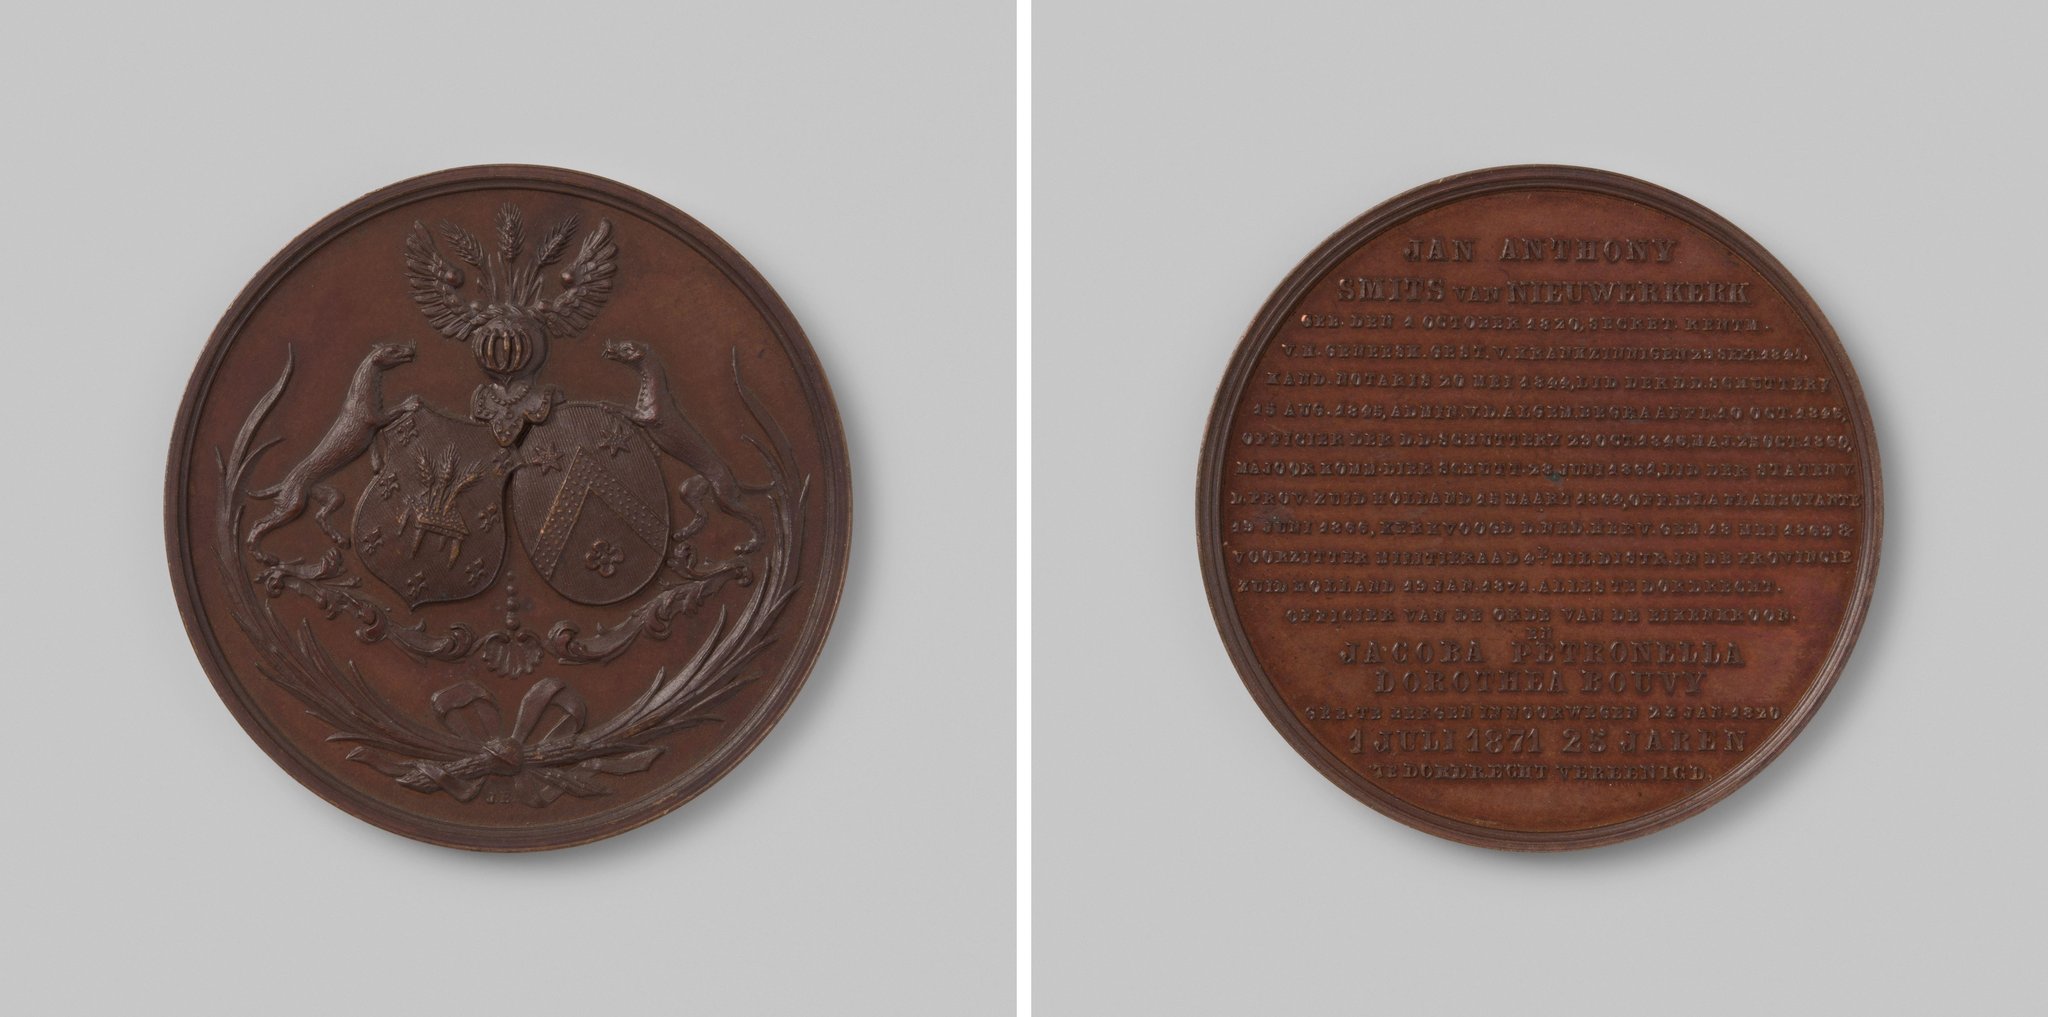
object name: marriage medal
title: Vijfentwintigjarig huwelijk van Jan Anthony Smits van Nieuwerkerk, lid van de Staten van Zuid-Holland en Jacoba Petronella Dorothea Bouvy te Dordrecht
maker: jacob samuel cohen elion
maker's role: draughtsman, painter, print maker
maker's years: 1840-1893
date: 1871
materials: bronze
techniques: striking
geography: amsterdam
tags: dordrecht, johan anthony smits van nieuwerkerk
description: Bronzen penning. Voorzijde: twee wapenschilden onder een gevleugelde helm, geflankeerd door twee dieren boven twee samengebonden palmtakken. Keerzijde: opschrift